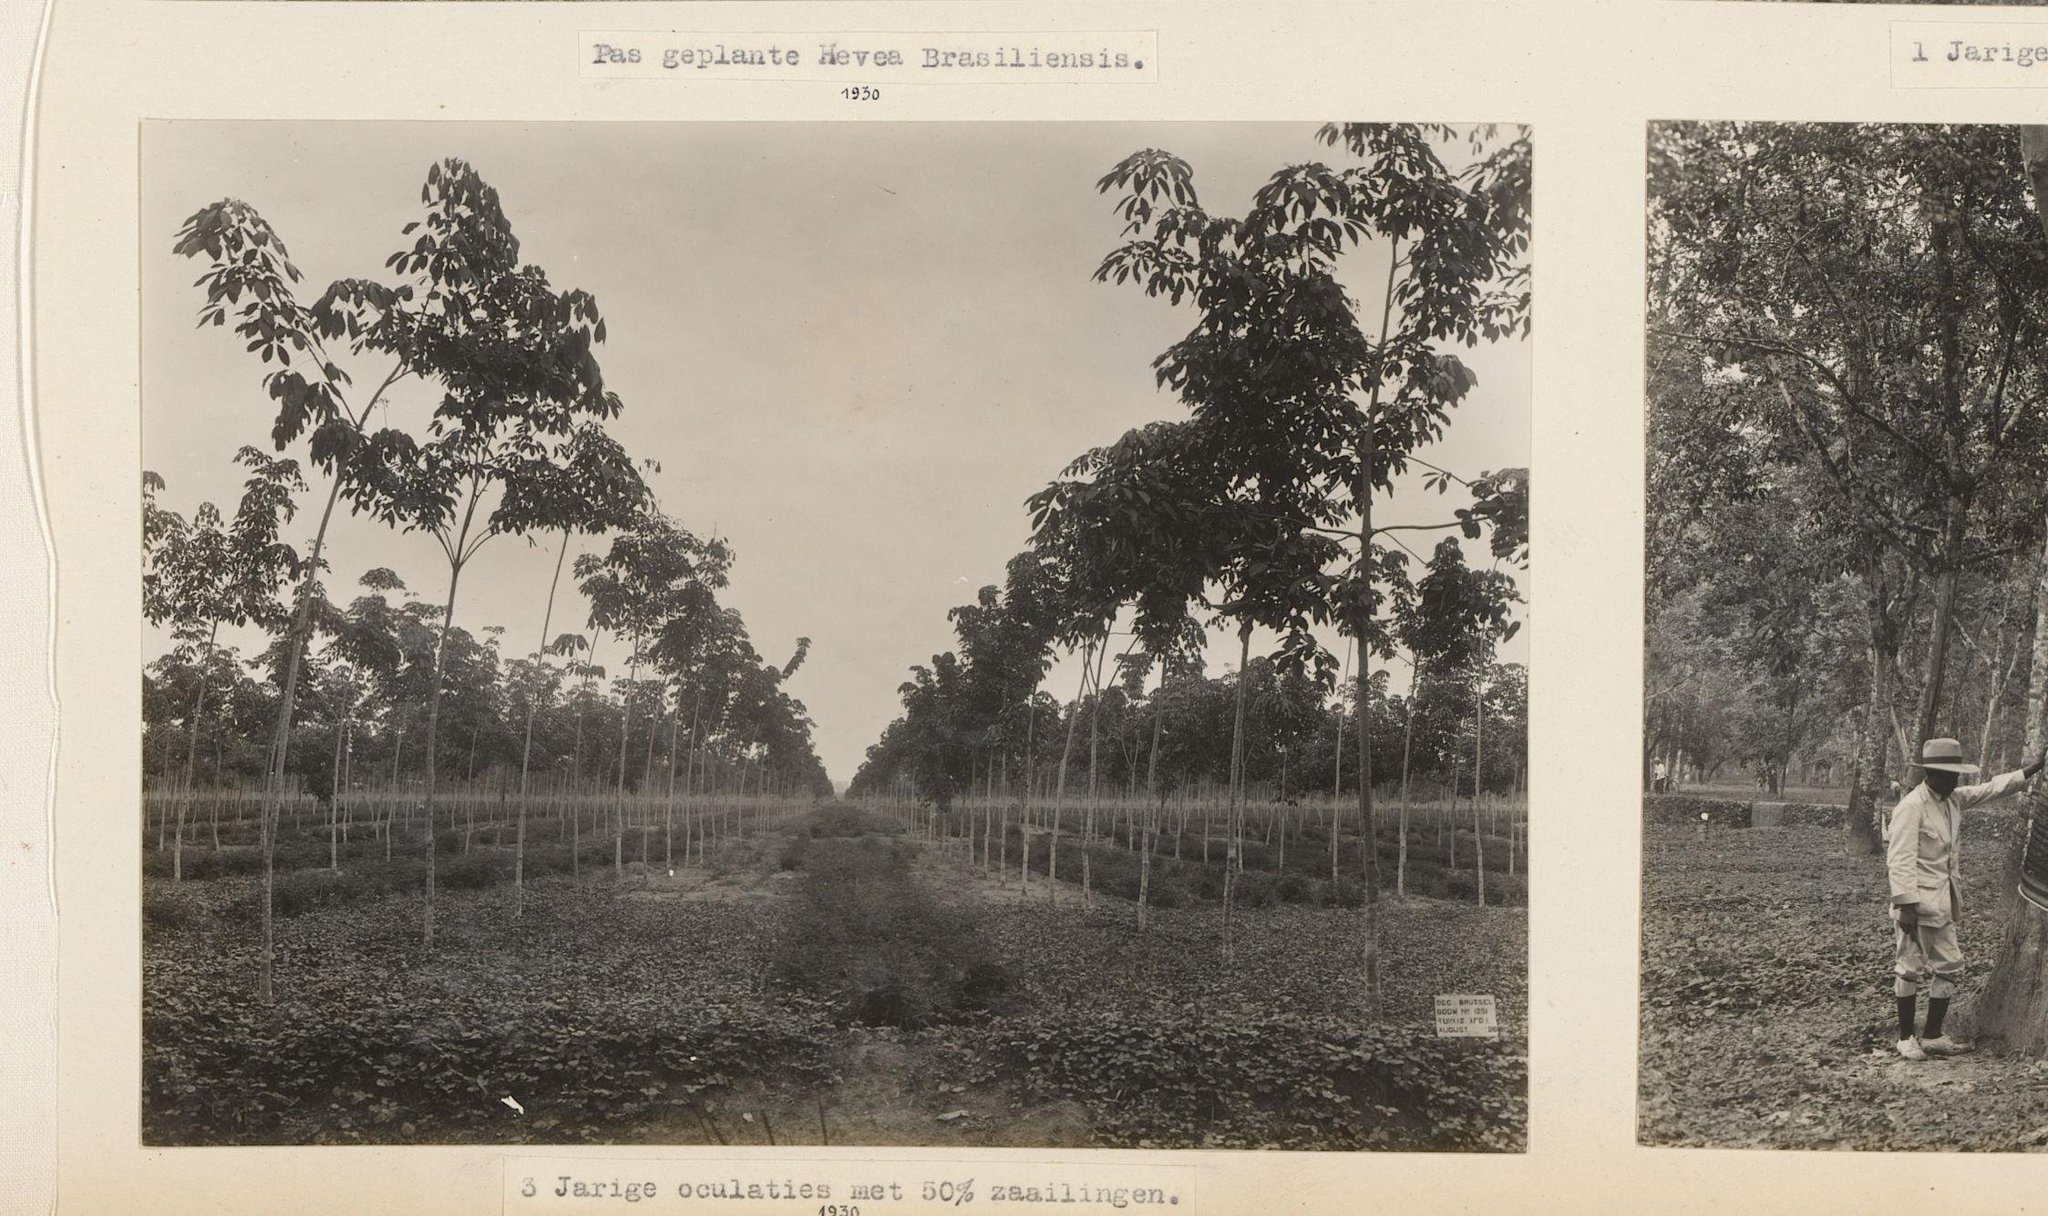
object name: album leaf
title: Jonge en oude rubberbomen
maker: Anonymous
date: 1930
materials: cardboard, photographic support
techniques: gelatin silver print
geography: sumatra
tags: plantation, (non-fruit) products of plants or trees: rubber, sumatra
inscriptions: inscription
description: Blad met vier foto's van jonge en oudere rubberbomen, 1930. Onder de foto's etiketten met onderschriften. Onderdeel van het fotoalbum over de plantages Brussel en Pernantian van de Sumatra Caoutchouc Maatschappij op de Oostkust van Sumatra in de jaren 1910-1935.